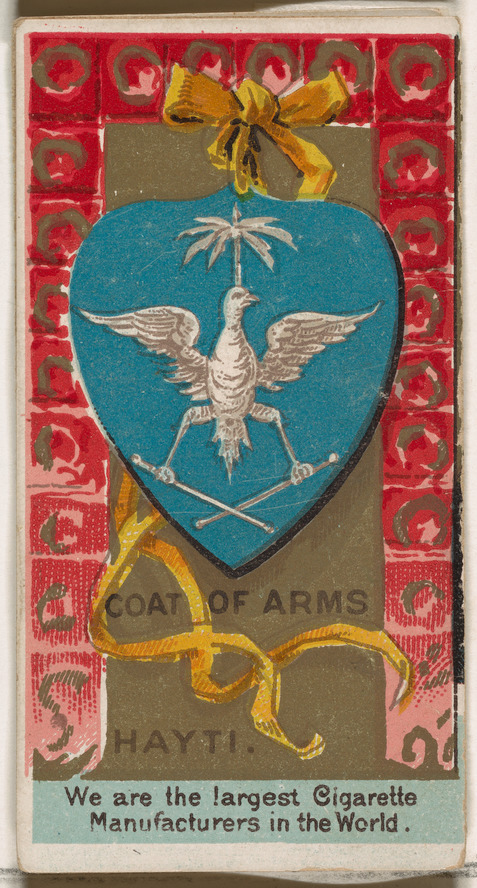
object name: print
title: President General Salomon of Haiti, from the Rulers, Flags, and Coats of Arms series (N126-2) issued by W. Duke, Sons & Co.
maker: w. duke, sons & co.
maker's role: publisher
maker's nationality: american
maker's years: 1870-1920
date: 1888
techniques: color lithograph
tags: men,portraits,coat of arms,flags,generals